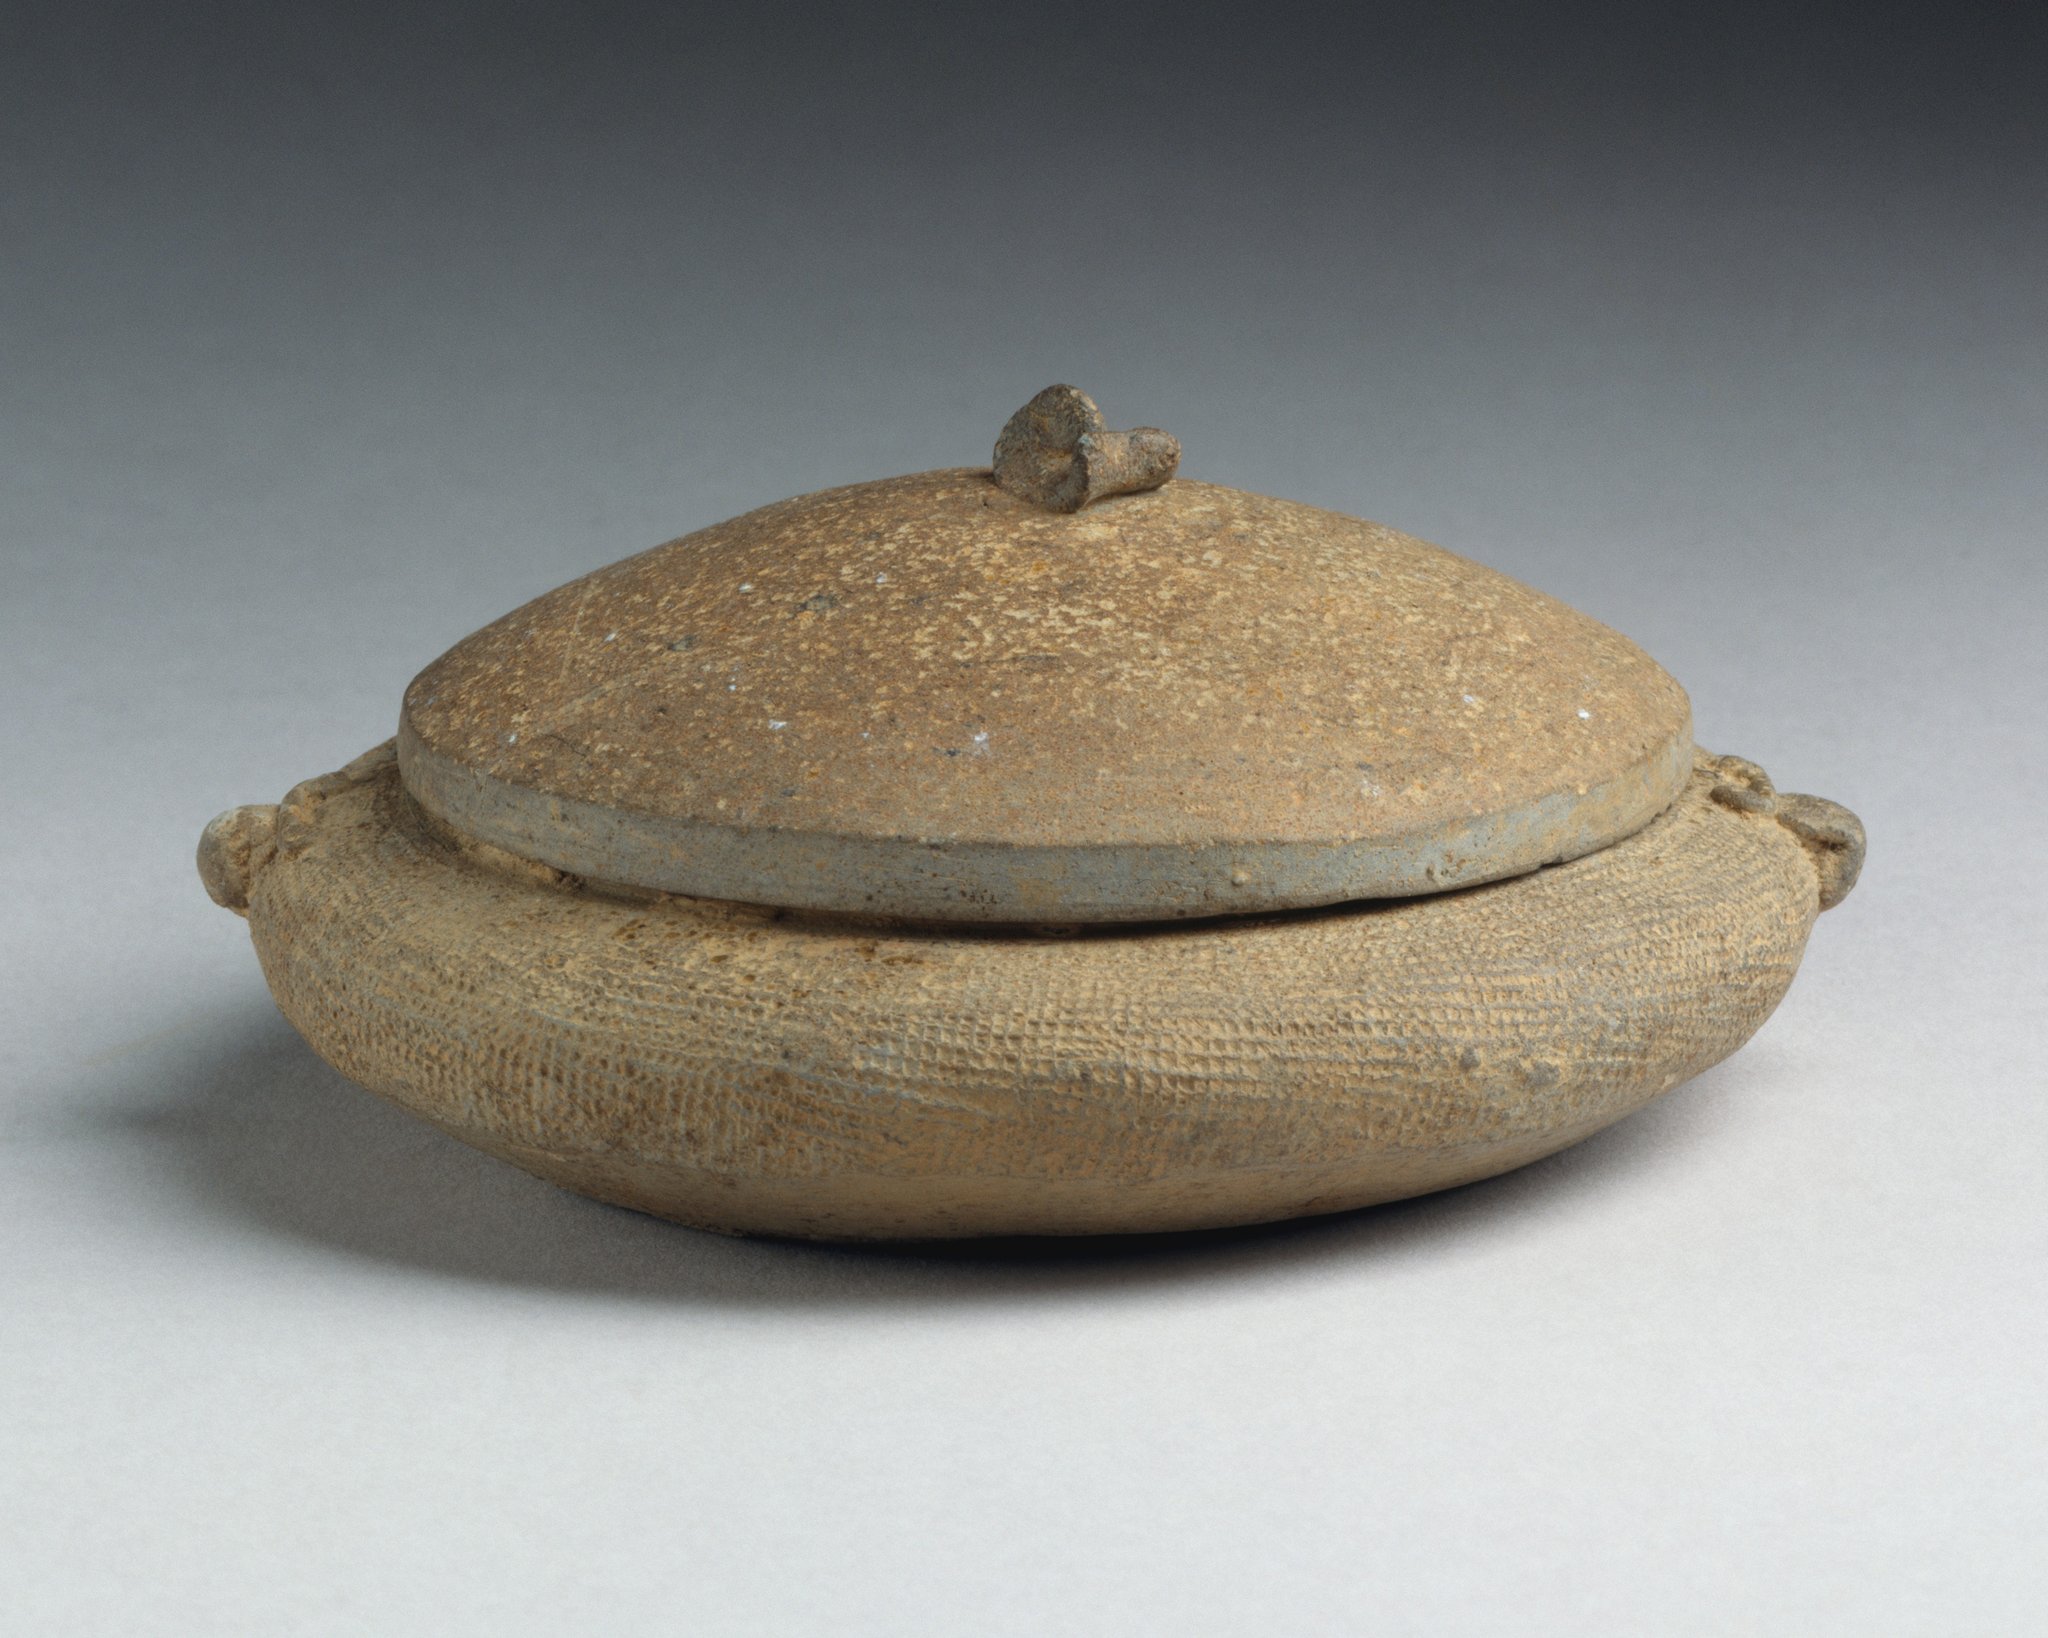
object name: covered jar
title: Covered jar (Guan)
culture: chinese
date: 500-335 BCE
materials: stoneware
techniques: relief